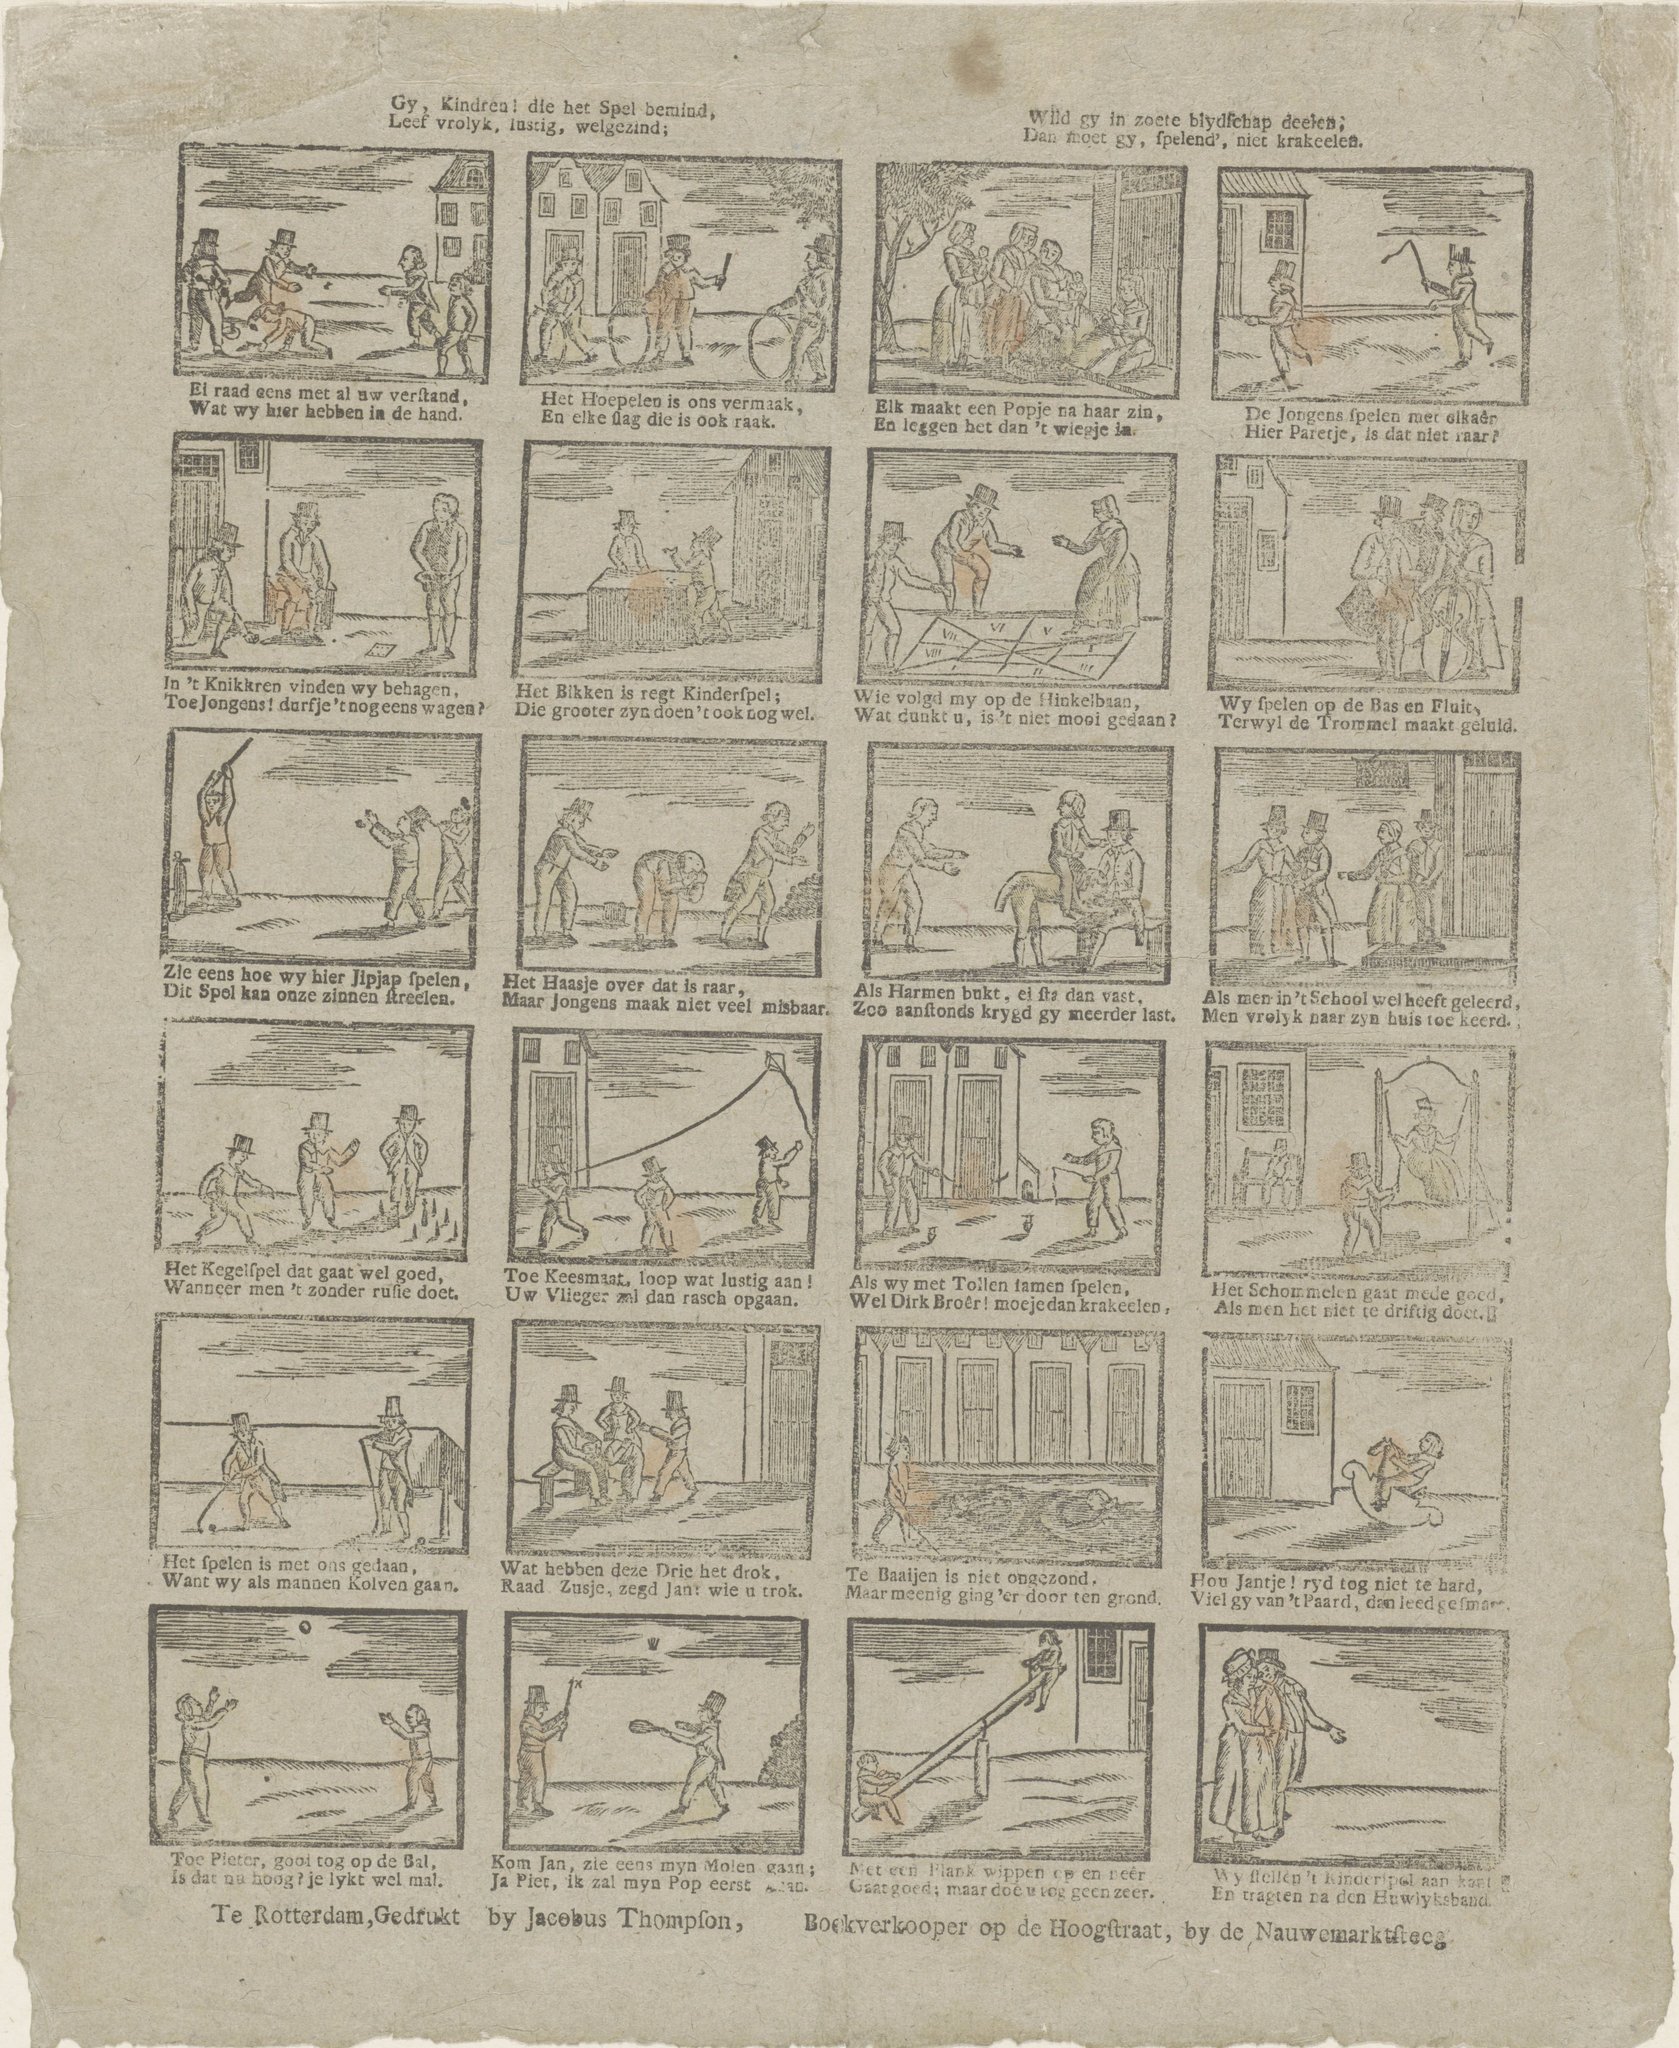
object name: print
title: Gy, kindren! die het spel bemind, / Leef vrolyk, lustig, welgezind; / Wild gy in zoete blydschap deelen, / Dan moet gy, spelend', niet krakeelen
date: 1791-1812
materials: paper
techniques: colour, letterpress printing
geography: rotterdam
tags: children's games and plays, bowling games (children's games), (flying a) kite, games using special objects (marbles, top, hoop, etc.)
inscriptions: collector's mark: Lugt 2760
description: Blad met 24 voorstellingen van kinderspelen, waaronder hoepelen, paardje spelen en haasje-over. Onder elke afbeelding een tweeregelig vers.